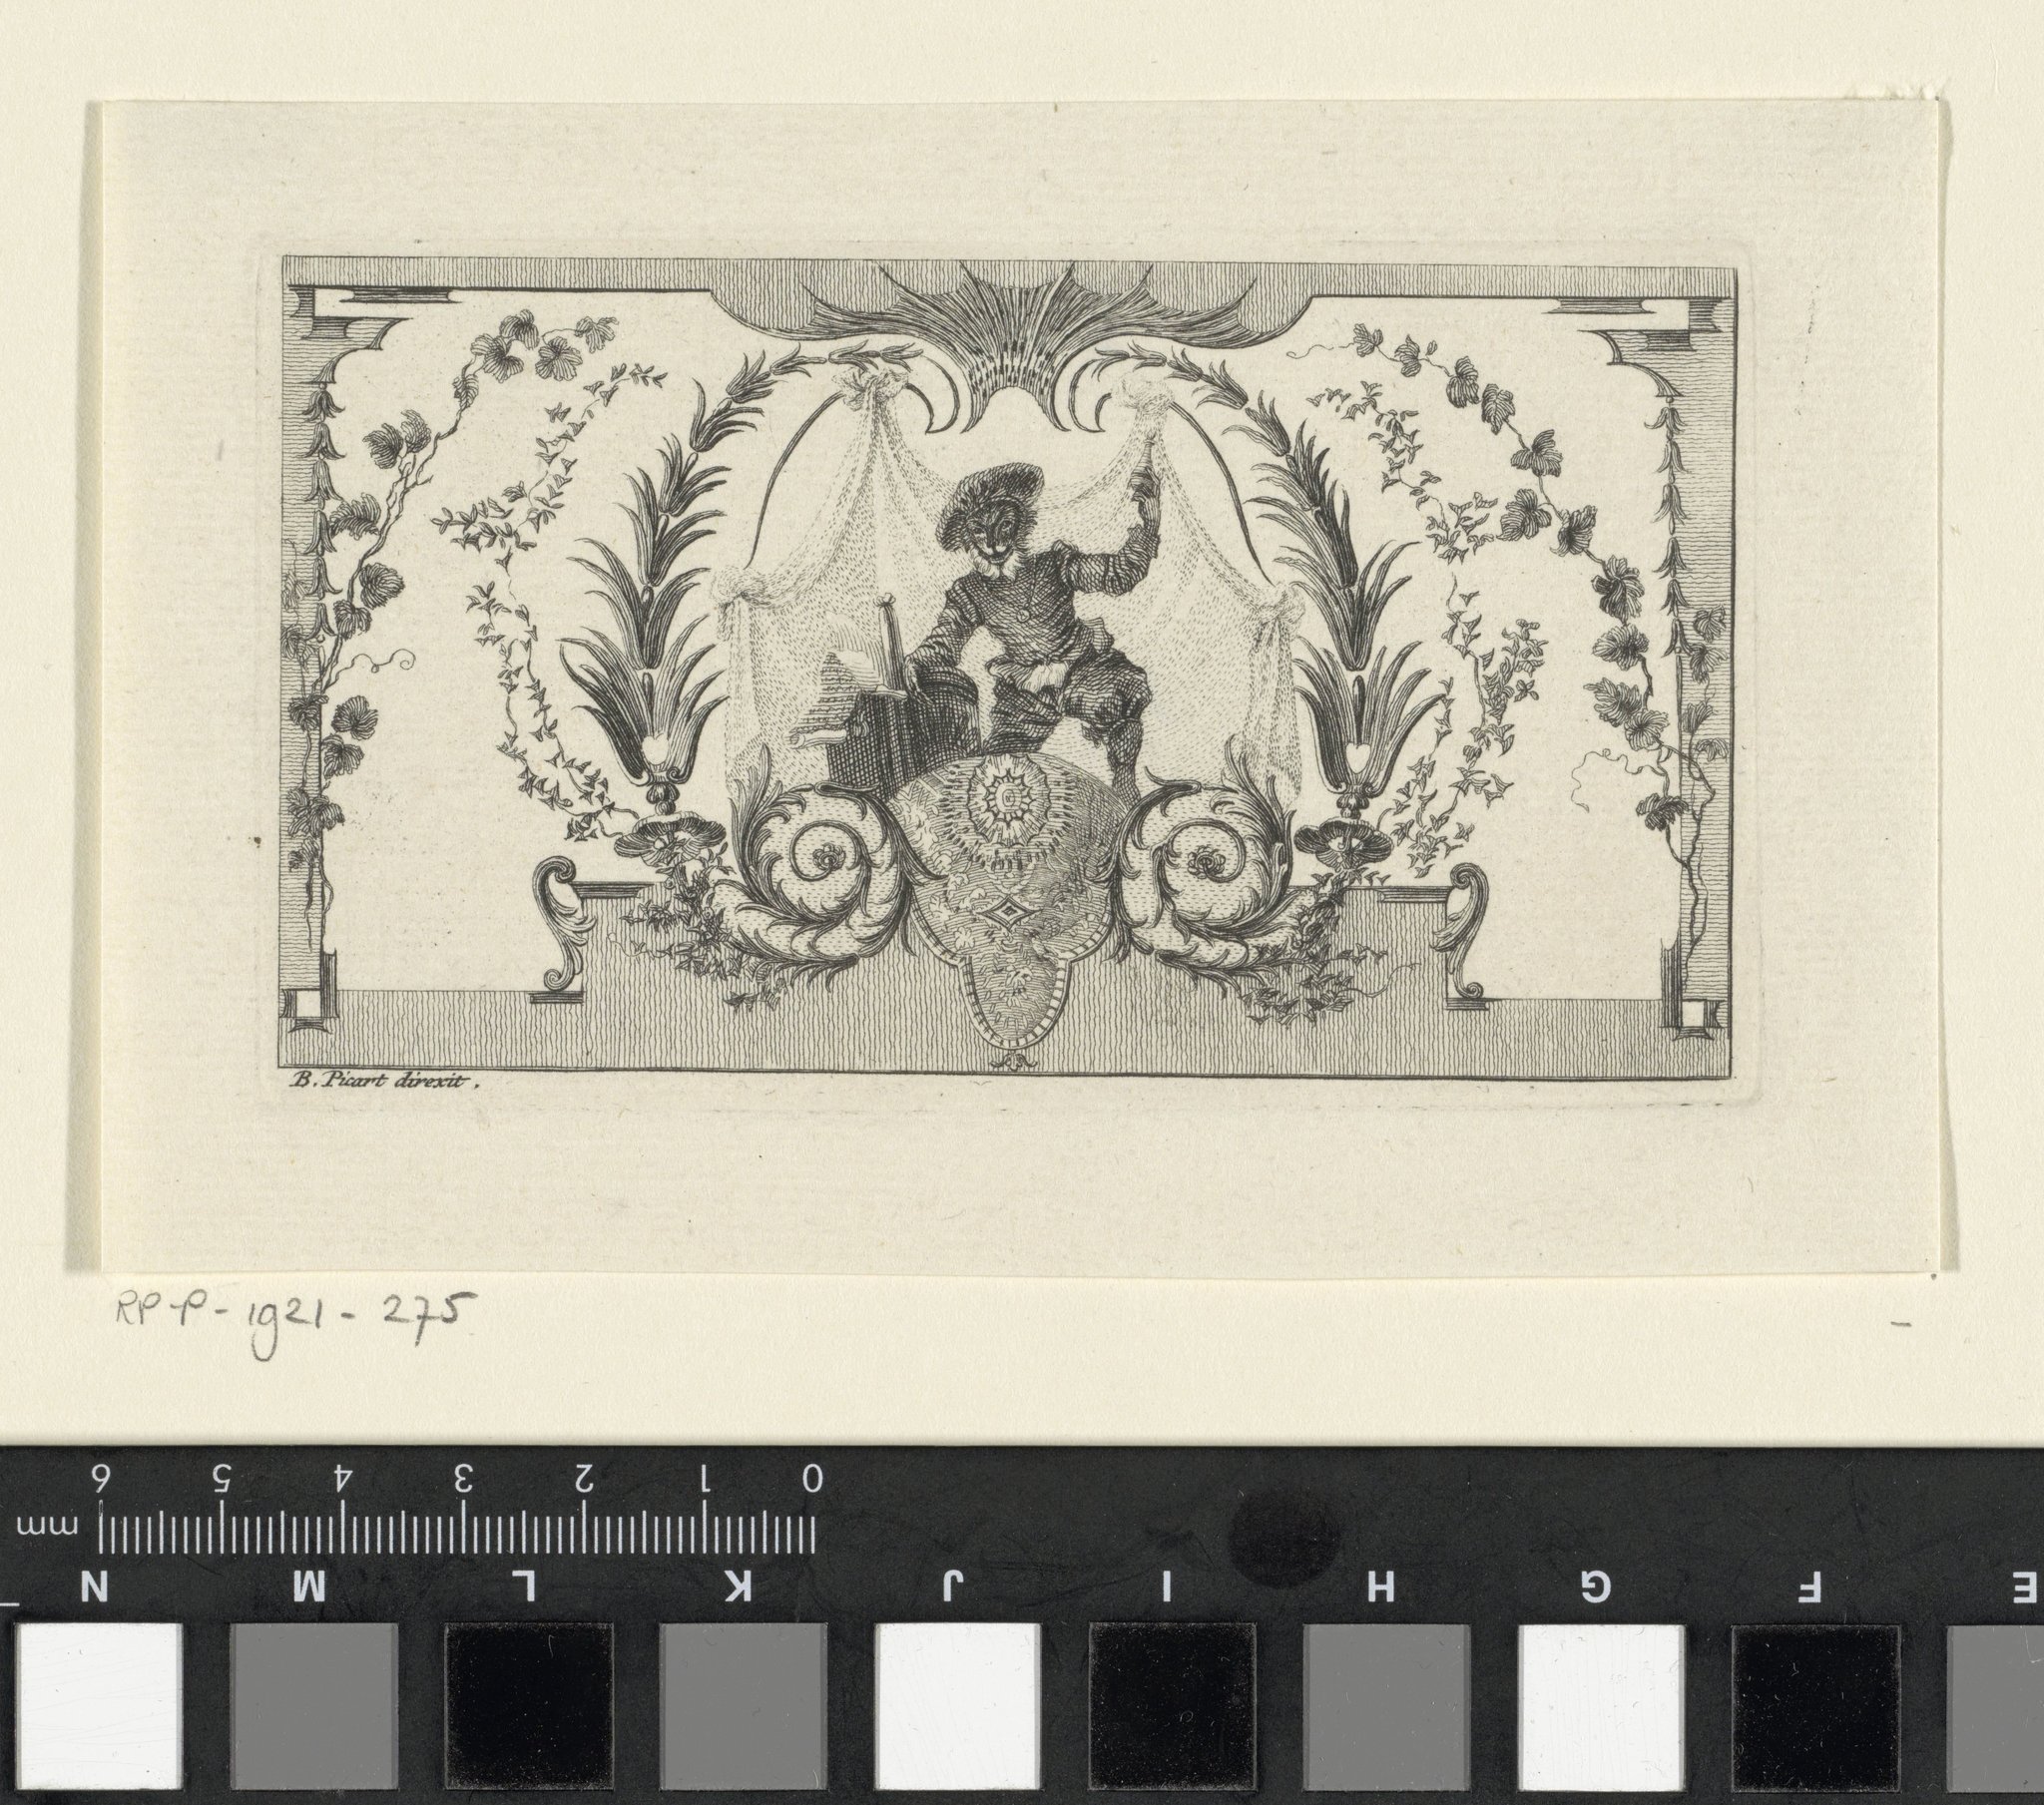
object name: print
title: Aap in mensenkleding omringd door bladornament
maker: bernard picart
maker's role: draughtsman, print maker, publisher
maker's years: 1673-1733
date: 1683-1733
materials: paper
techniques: engraving, etching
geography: amsterdam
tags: monkeys, apes, foliage, tendrils, branches ~ ornament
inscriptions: collector's mark: Lugt 2233